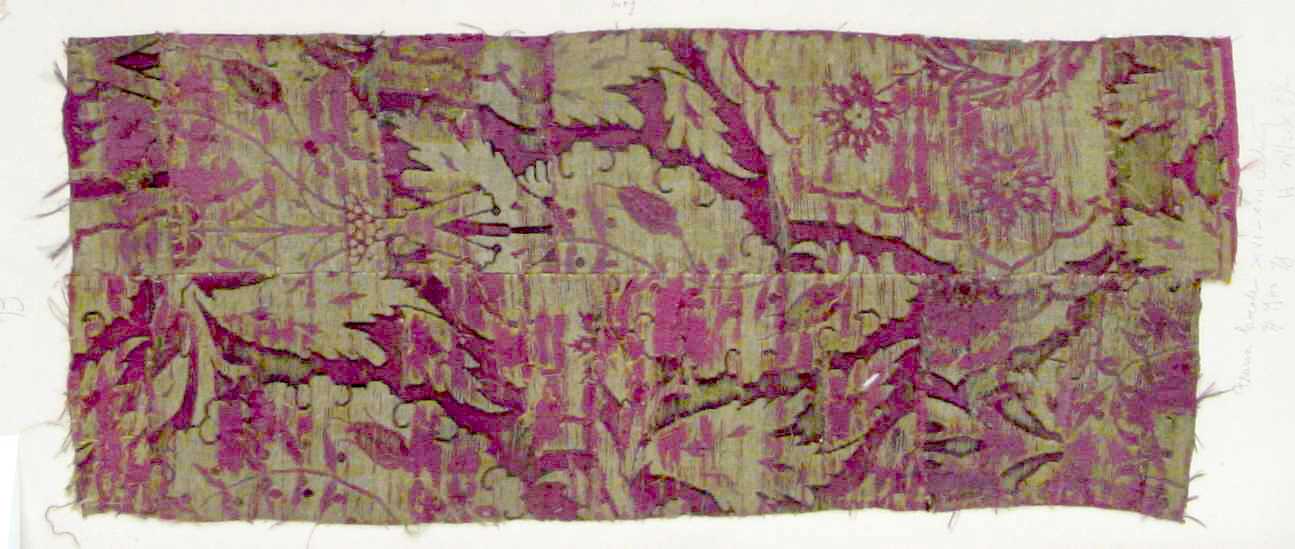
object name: textile fragment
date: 1501-1700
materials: metal thread, silk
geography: turkey